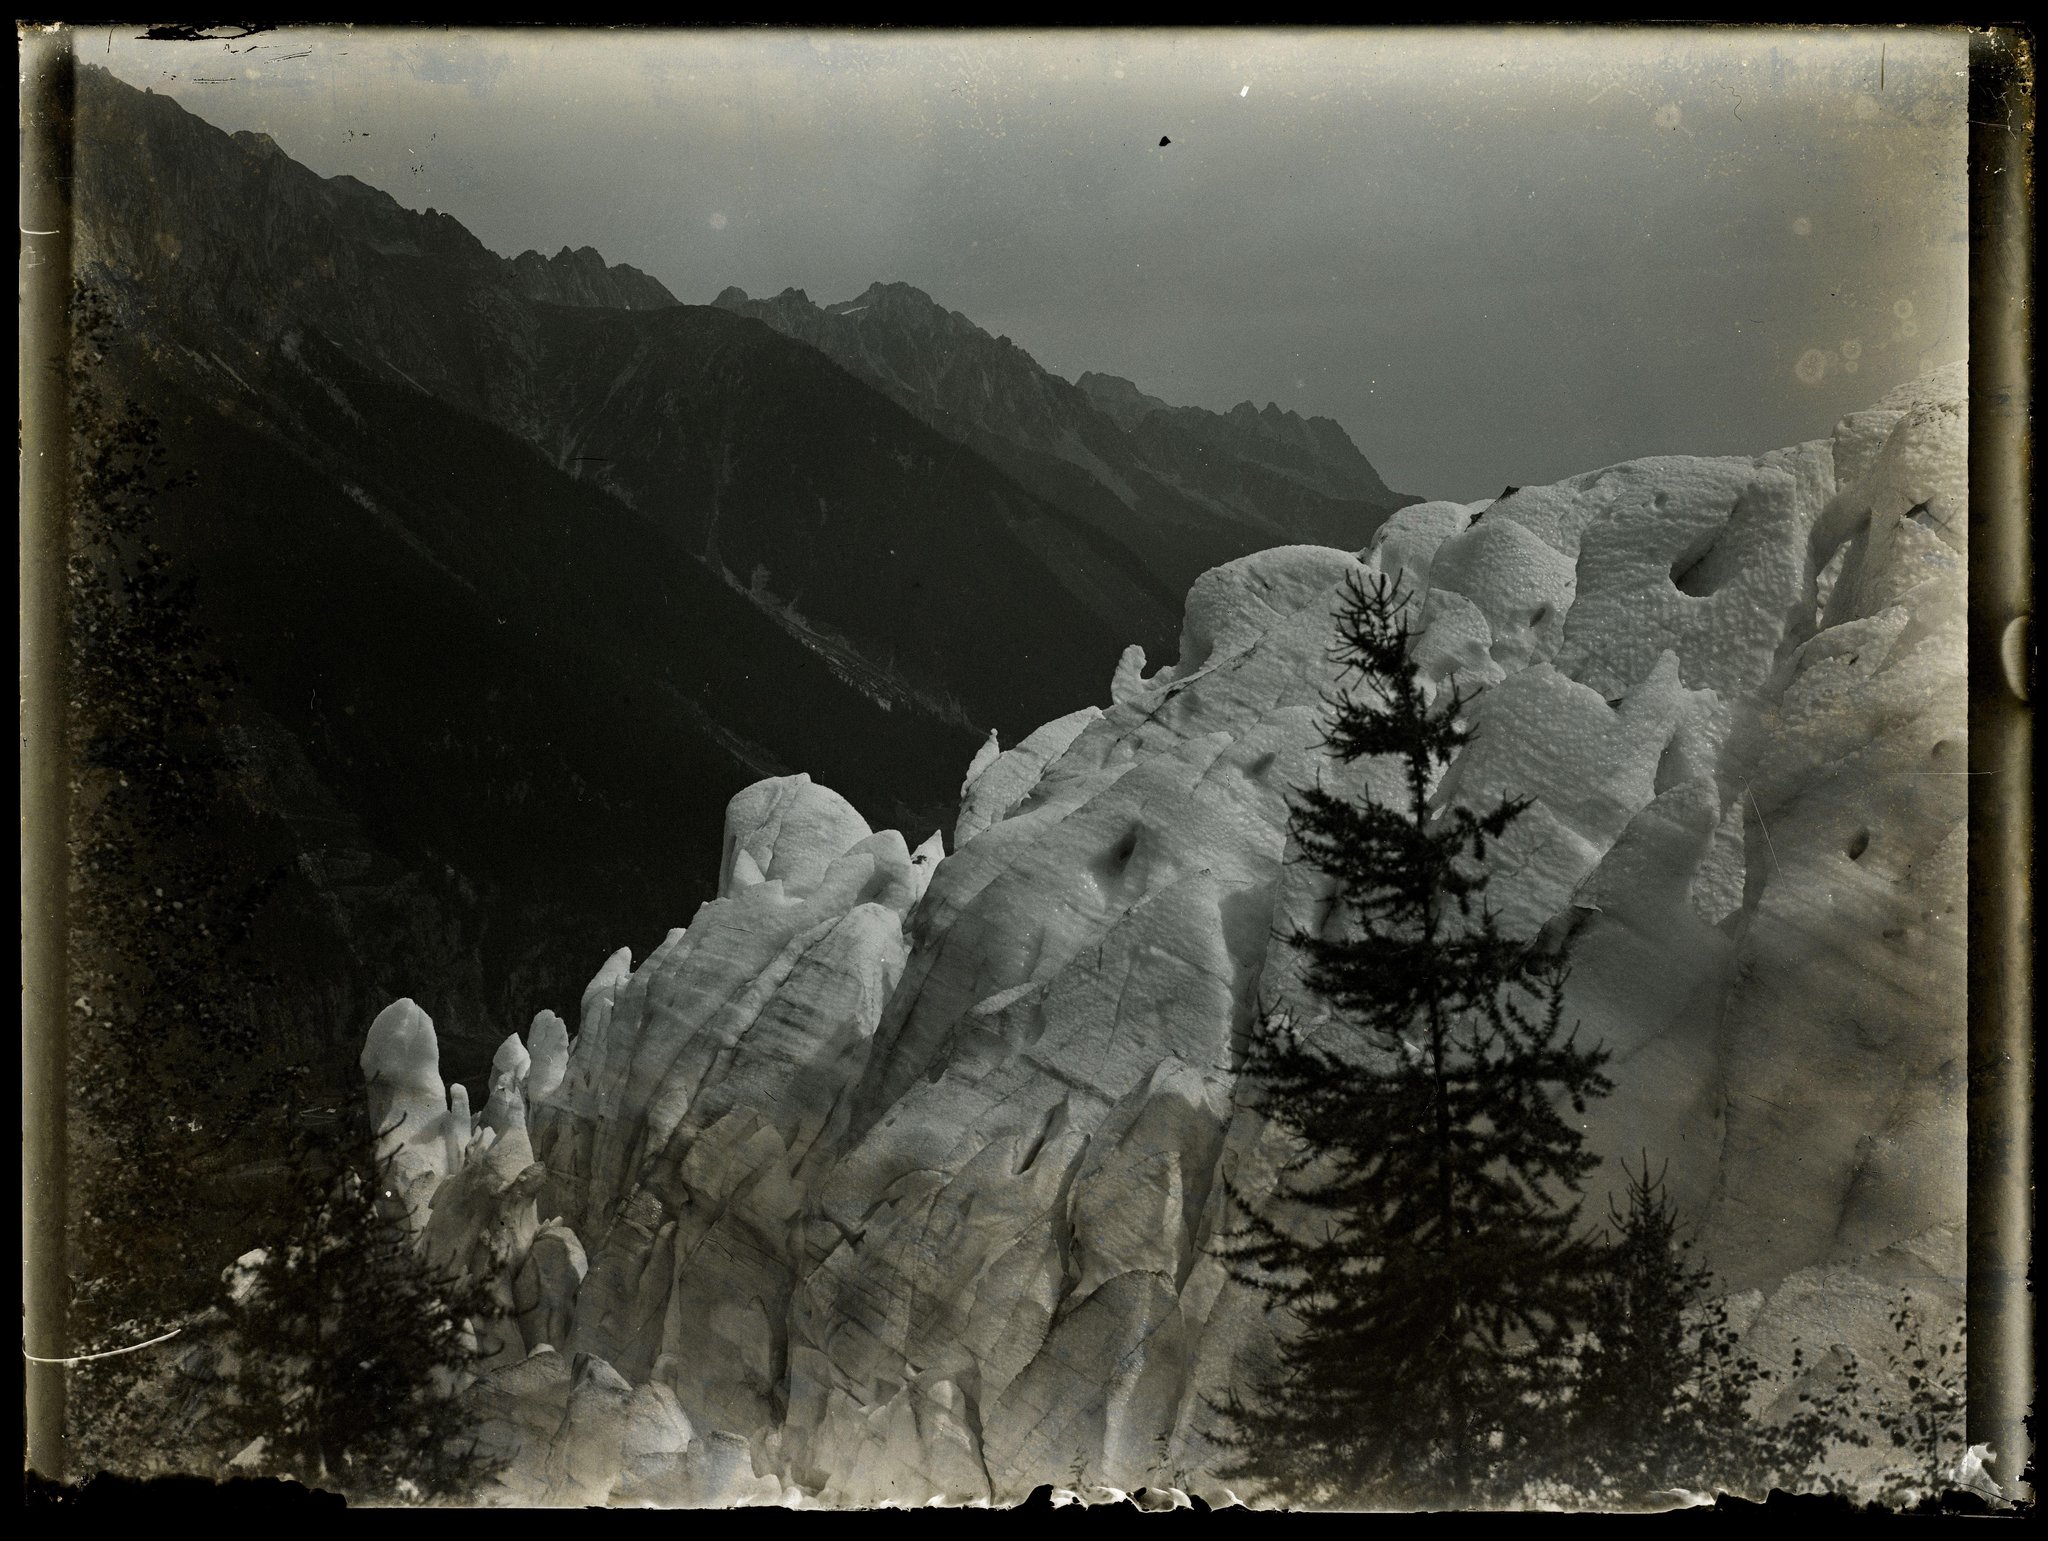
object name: glasnegatief, glasplaatnegatief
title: Berglandschap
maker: Anonymous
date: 1907-1935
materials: glass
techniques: gelatin glass negative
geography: europe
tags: mountains, europe